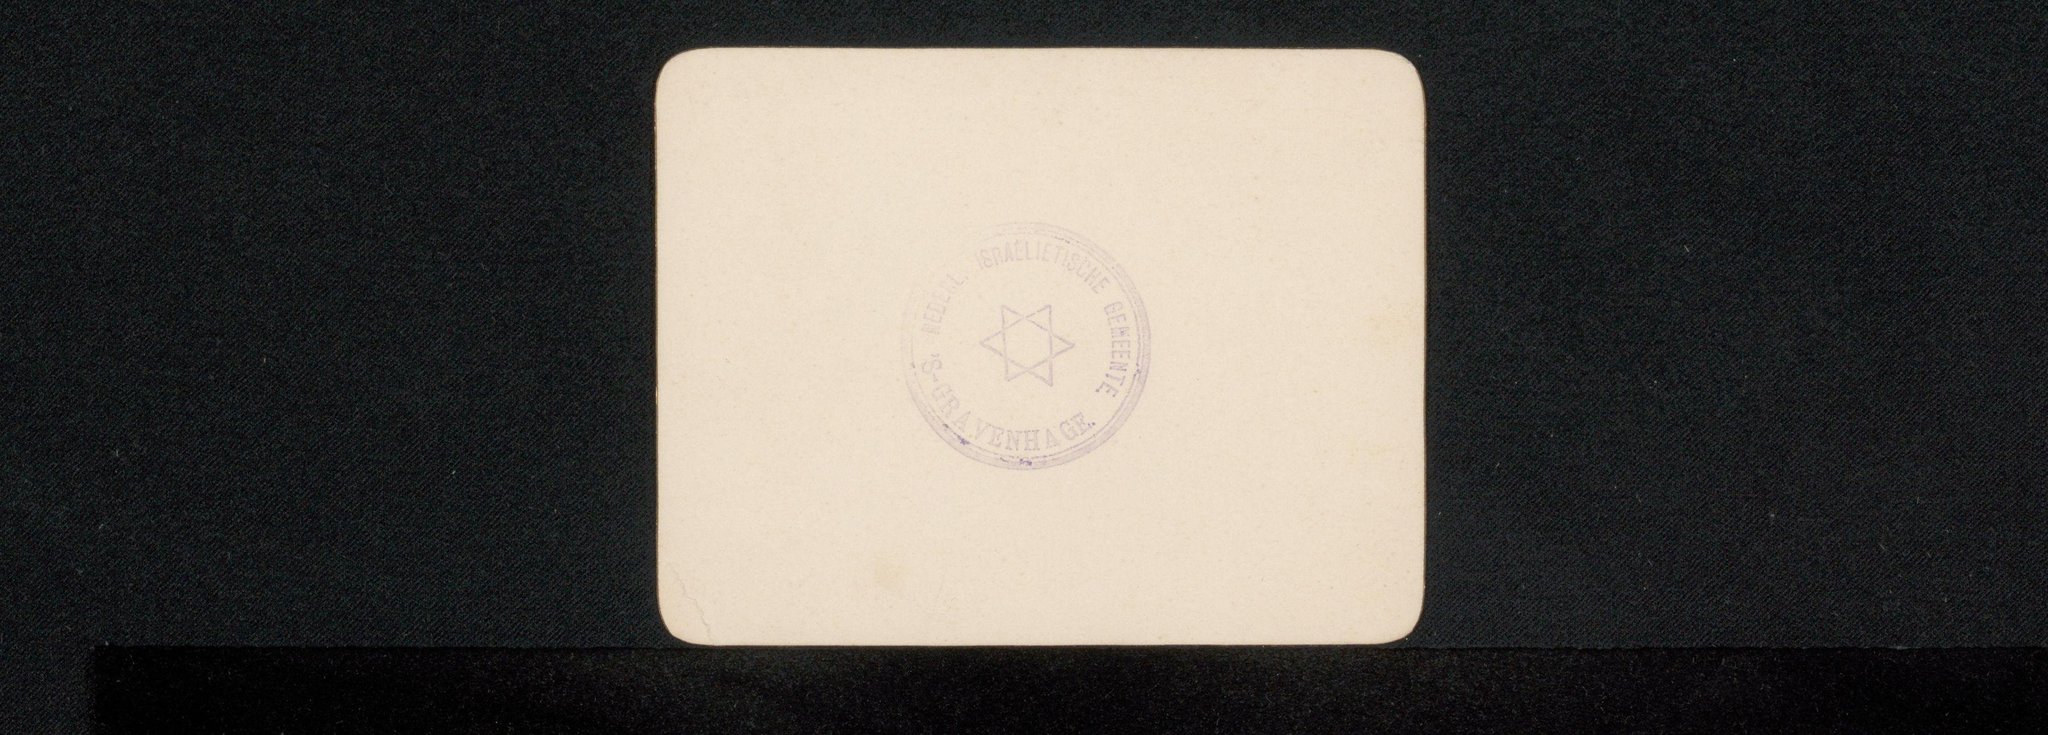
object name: visiting card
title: Visitekaartje aan Philip Zicken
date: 1867-1930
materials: cardboard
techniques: printing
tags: painter, draughtsman, philip zilcken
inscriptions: collector's mark: ‘RPK’, name: ‘RPK’